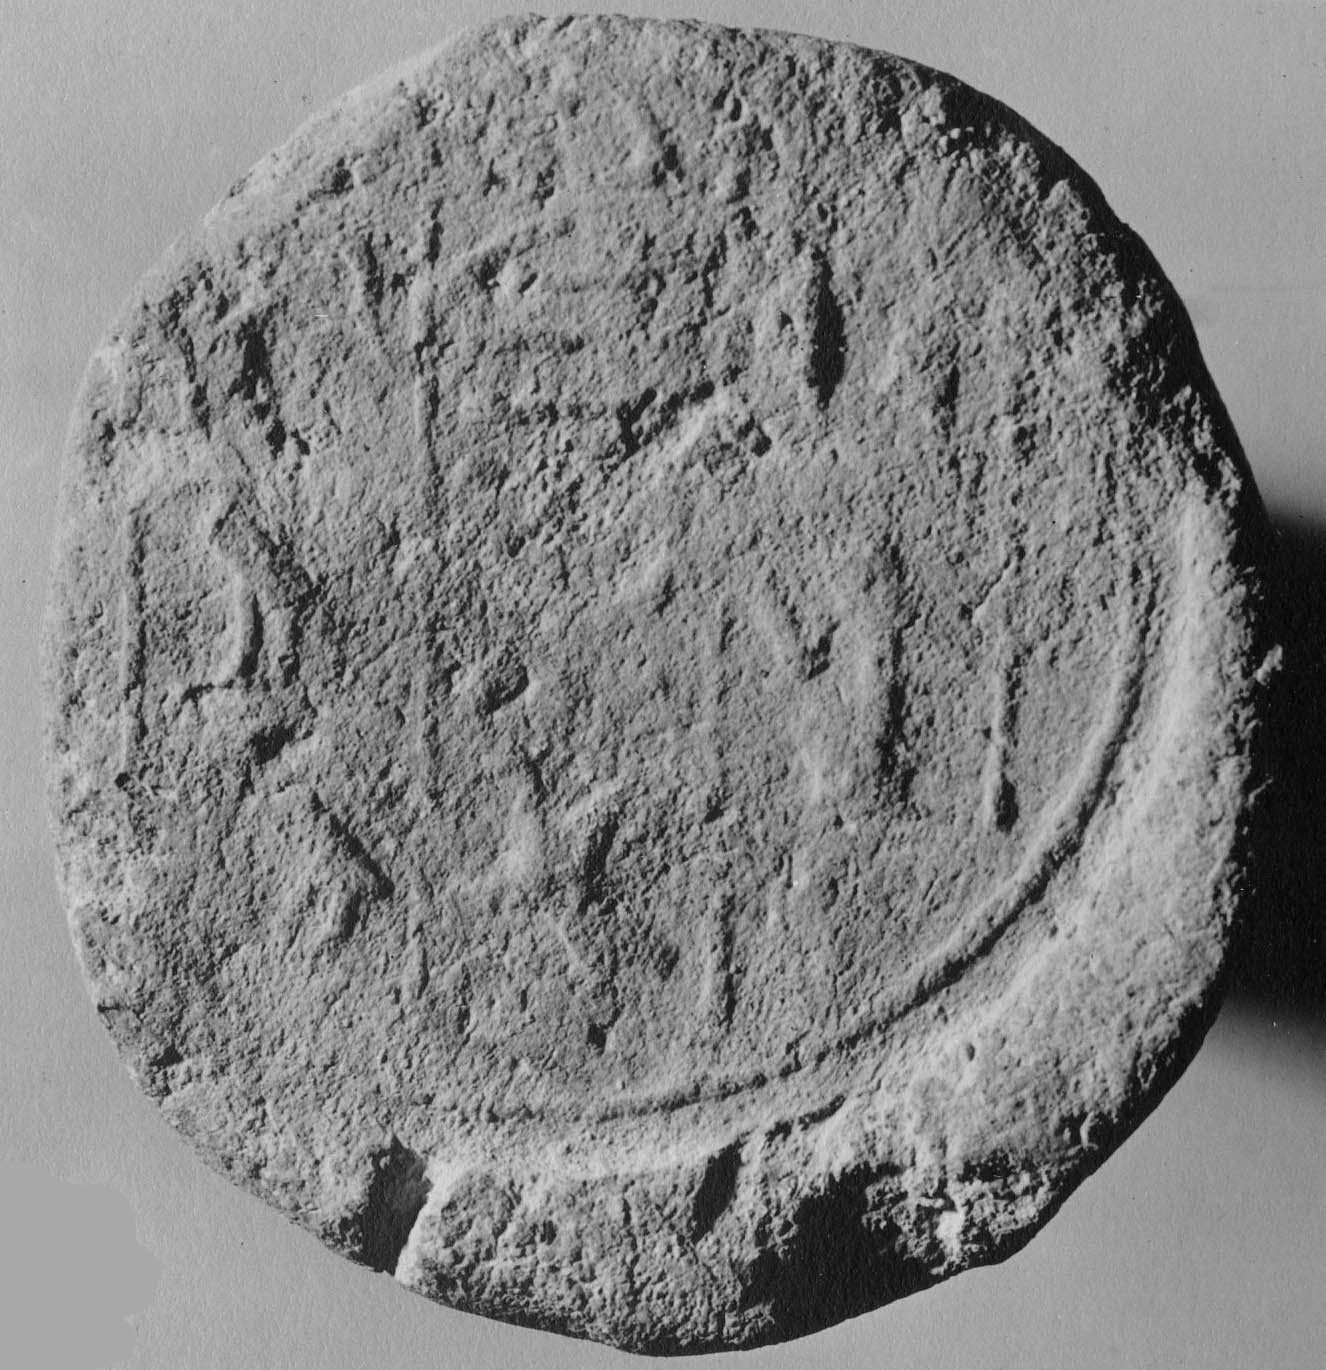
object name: cone, tjay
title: Funerary Cone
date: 1550-1295 BCE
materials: pottery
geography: egypt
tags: hieroglyphs